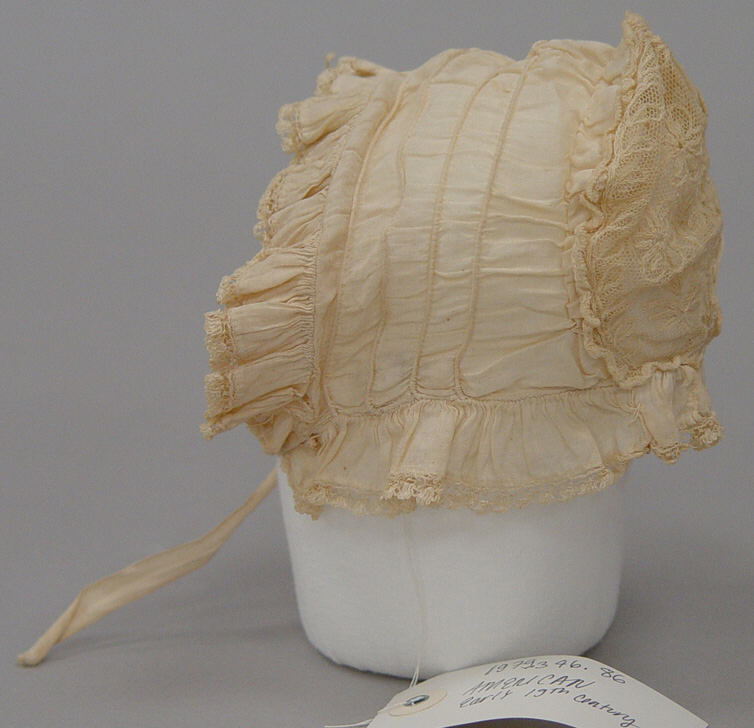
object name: bonnet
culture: american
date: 1800-1850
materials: cotton